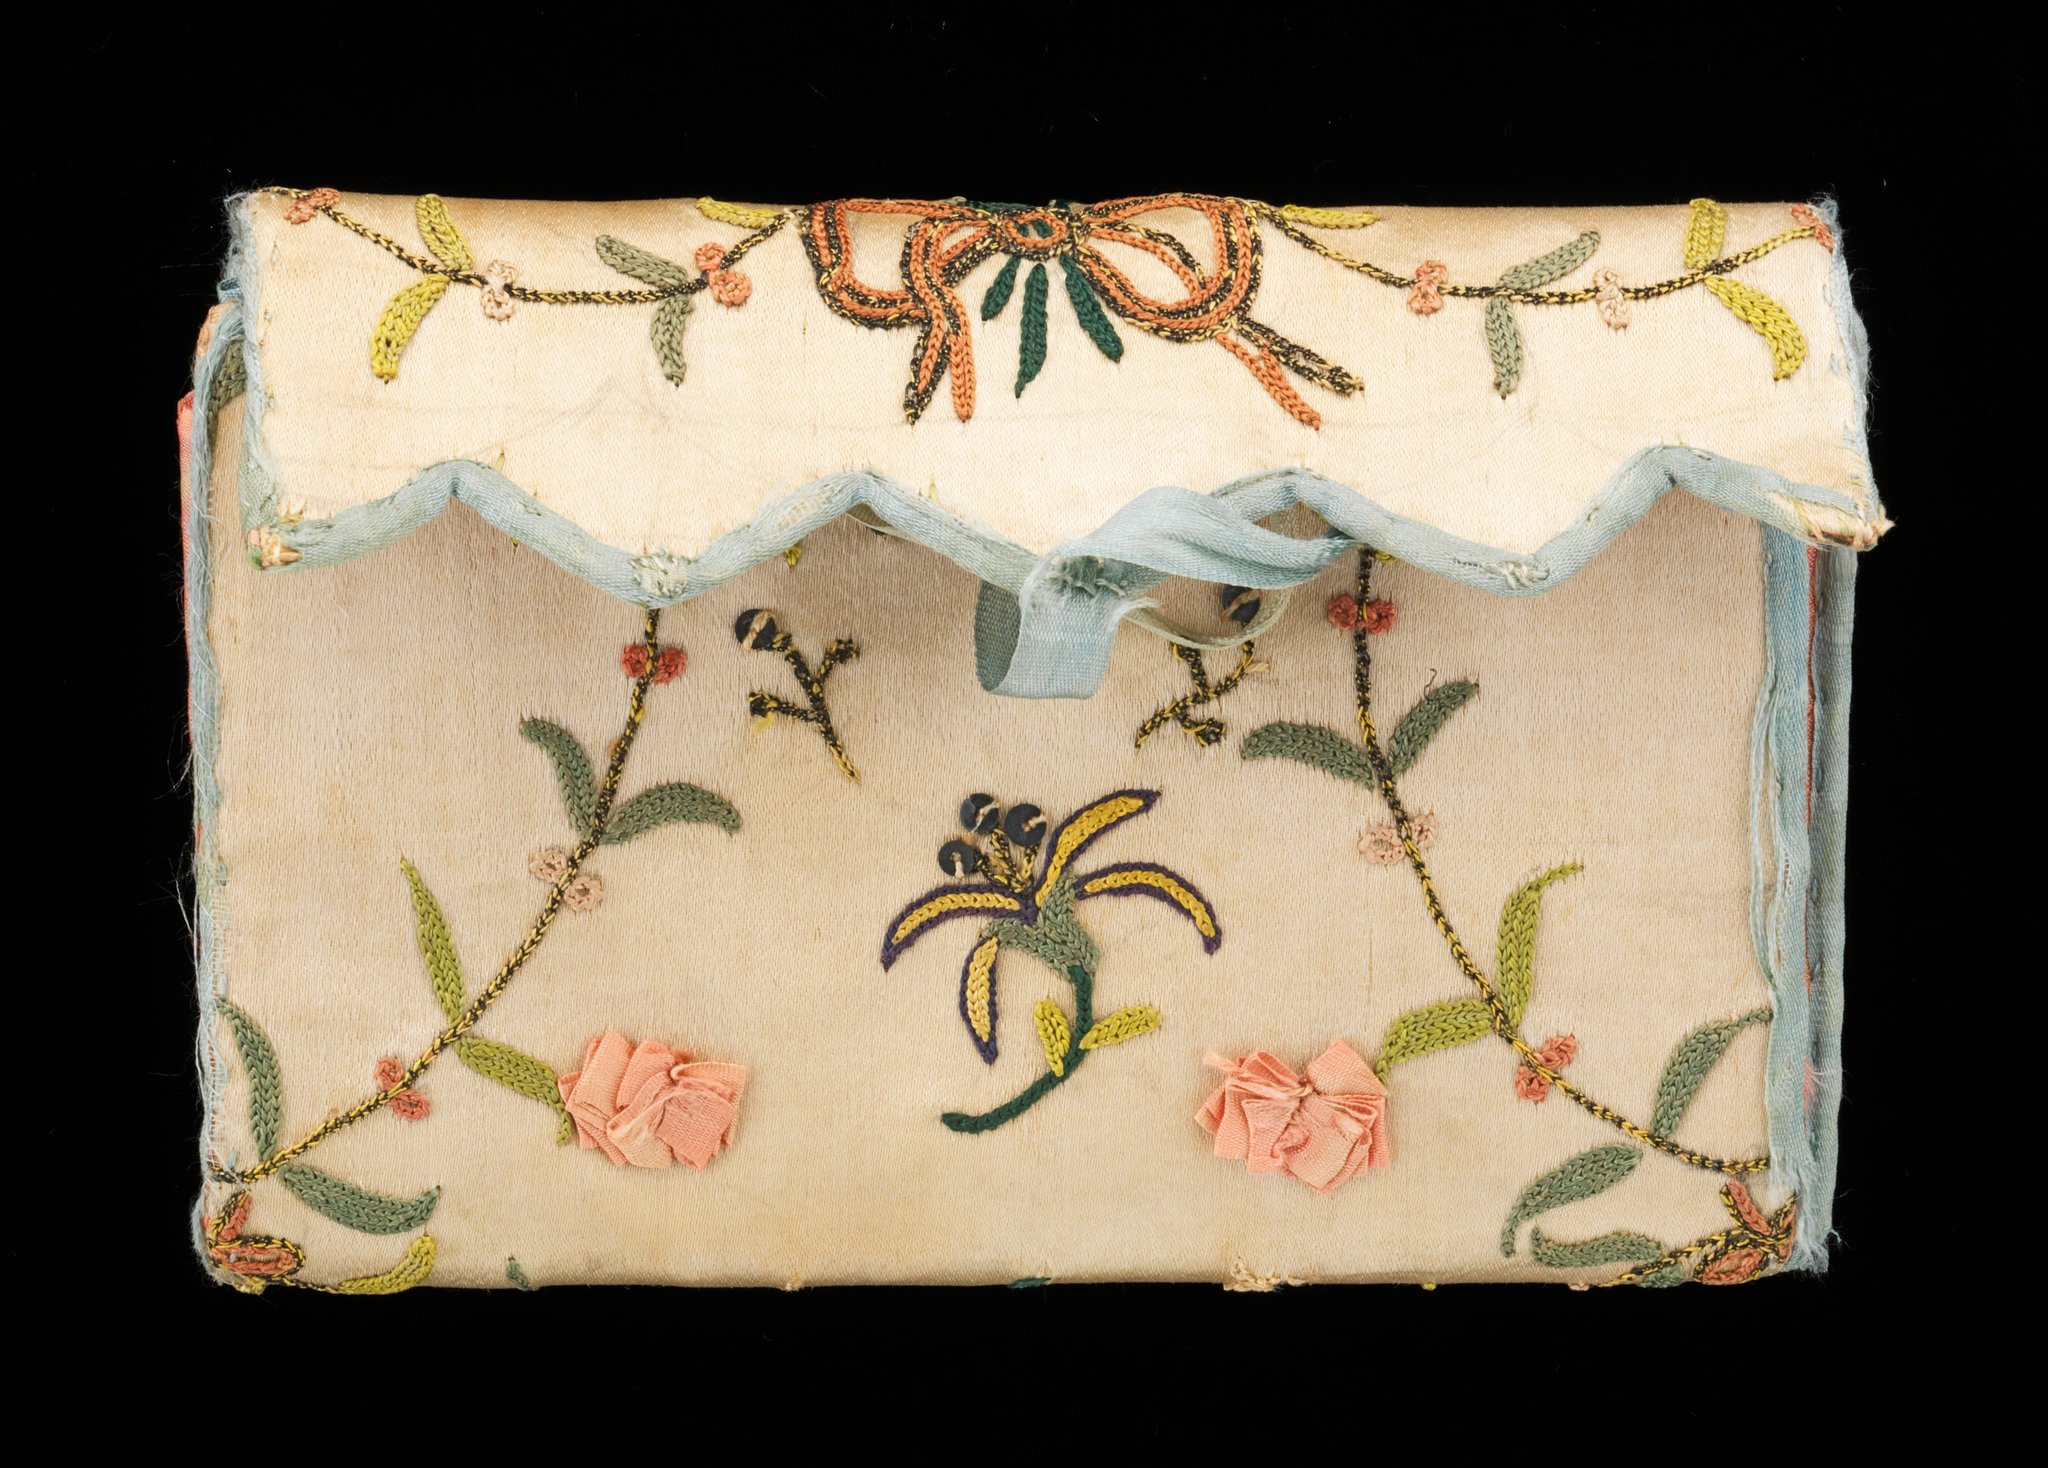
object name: purse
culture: american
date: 1776-1800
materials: paper, silk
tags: flowers